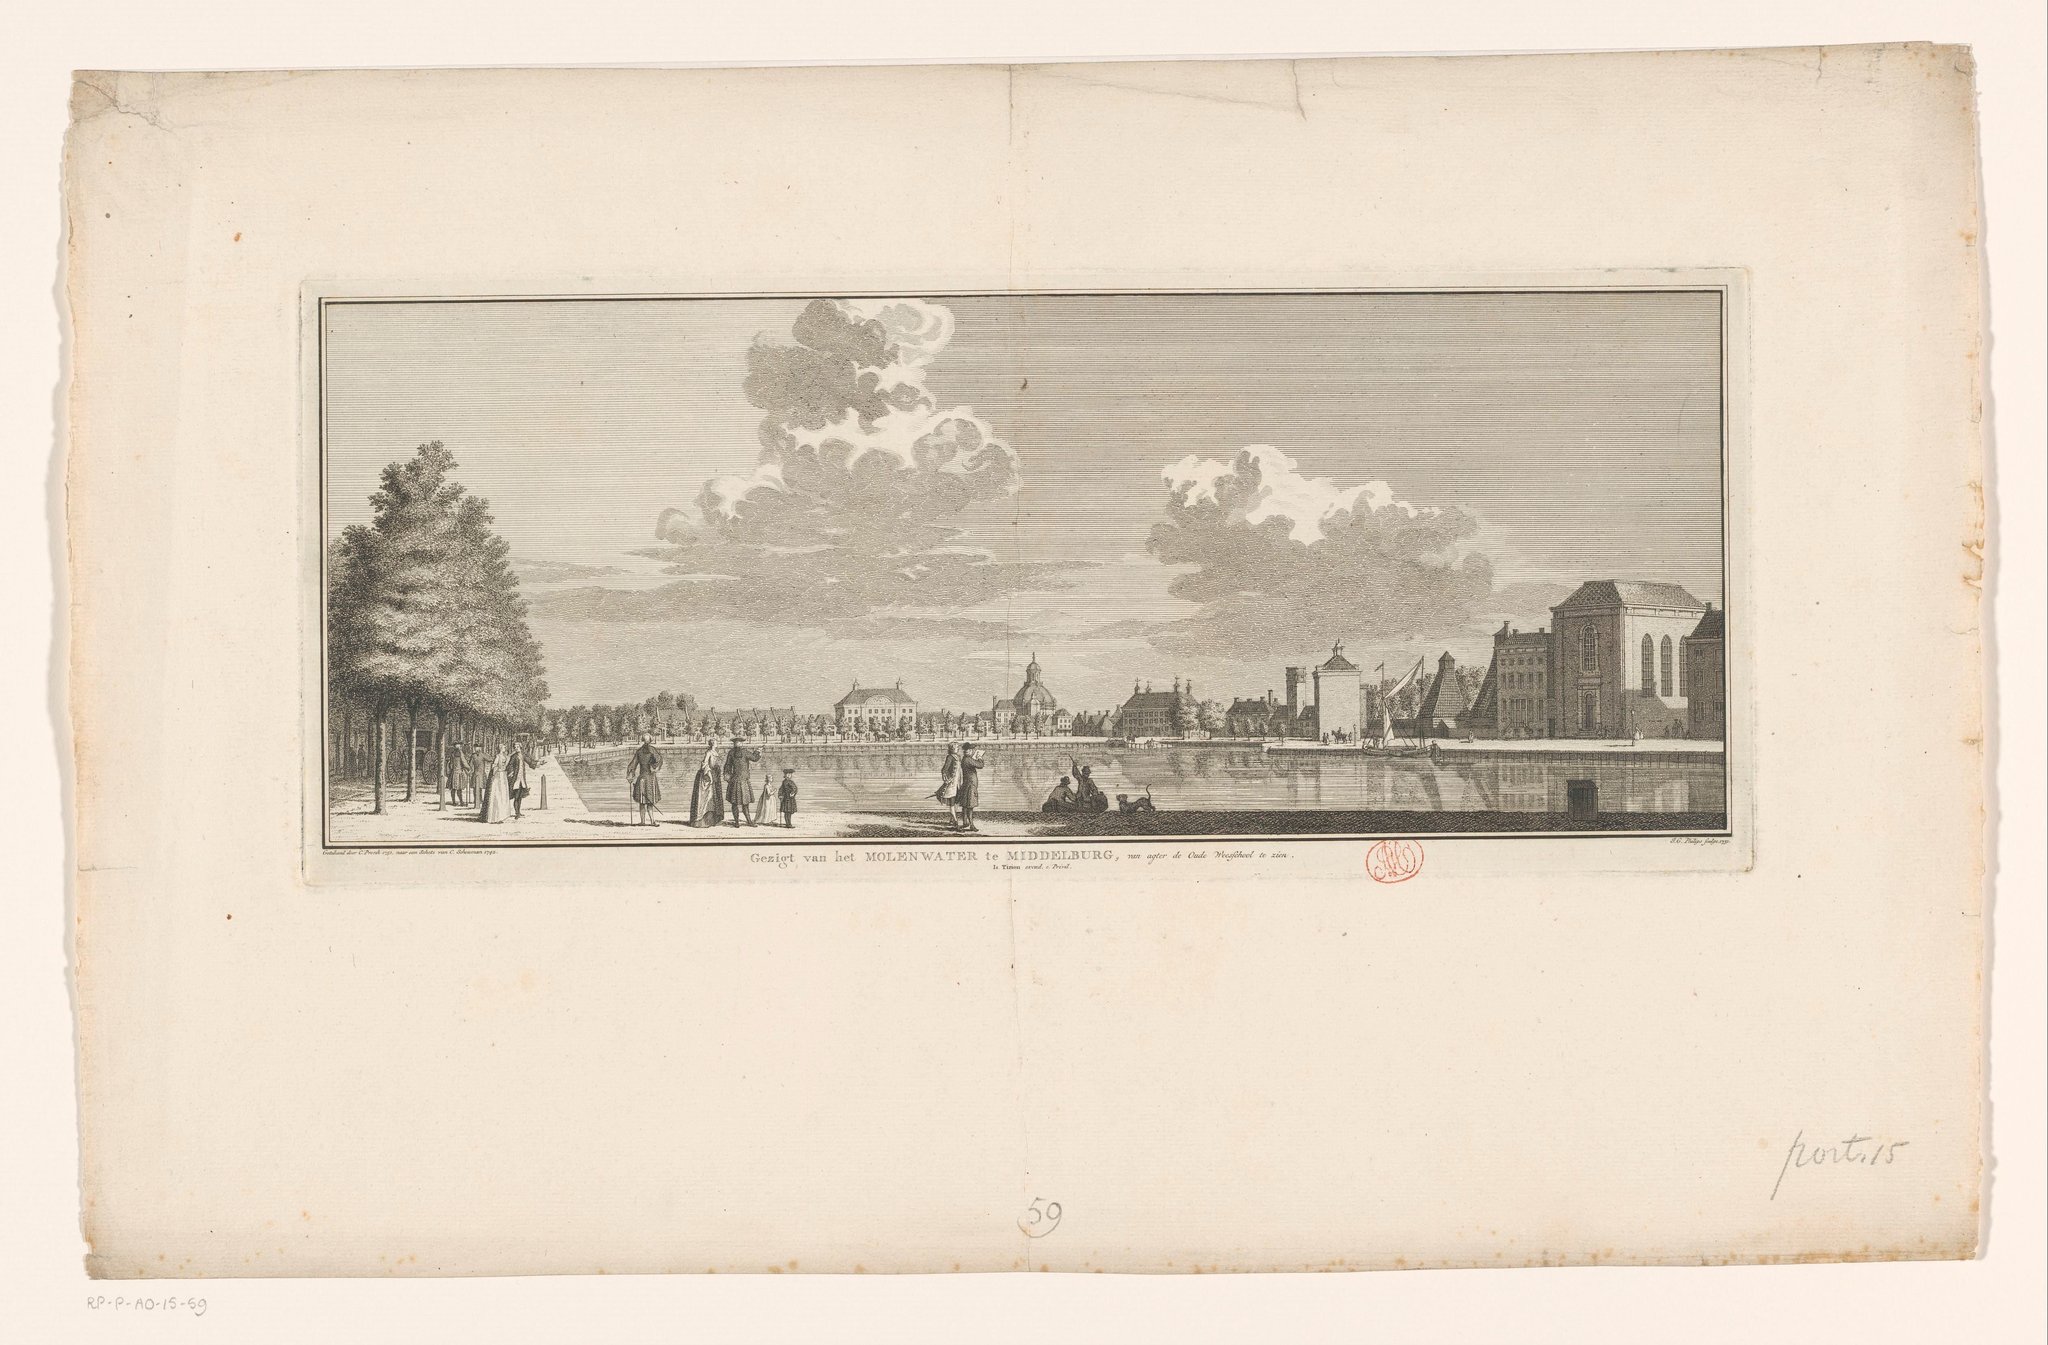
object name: print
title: Gezicht op het Molenwater te Middelburg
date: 1751-1760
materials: paper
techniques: engraving, etching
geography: amsterdam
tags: church (exterior), pond, pool, prospect of city, town panorama, silhouette of city, middelburg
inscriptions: collector's mark: Lugt 195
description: Gezicht op het Molenwater te Middelburg, gezien van achter het Oude Weesschool. Op de achtergrond in het midden de Oostkerk.